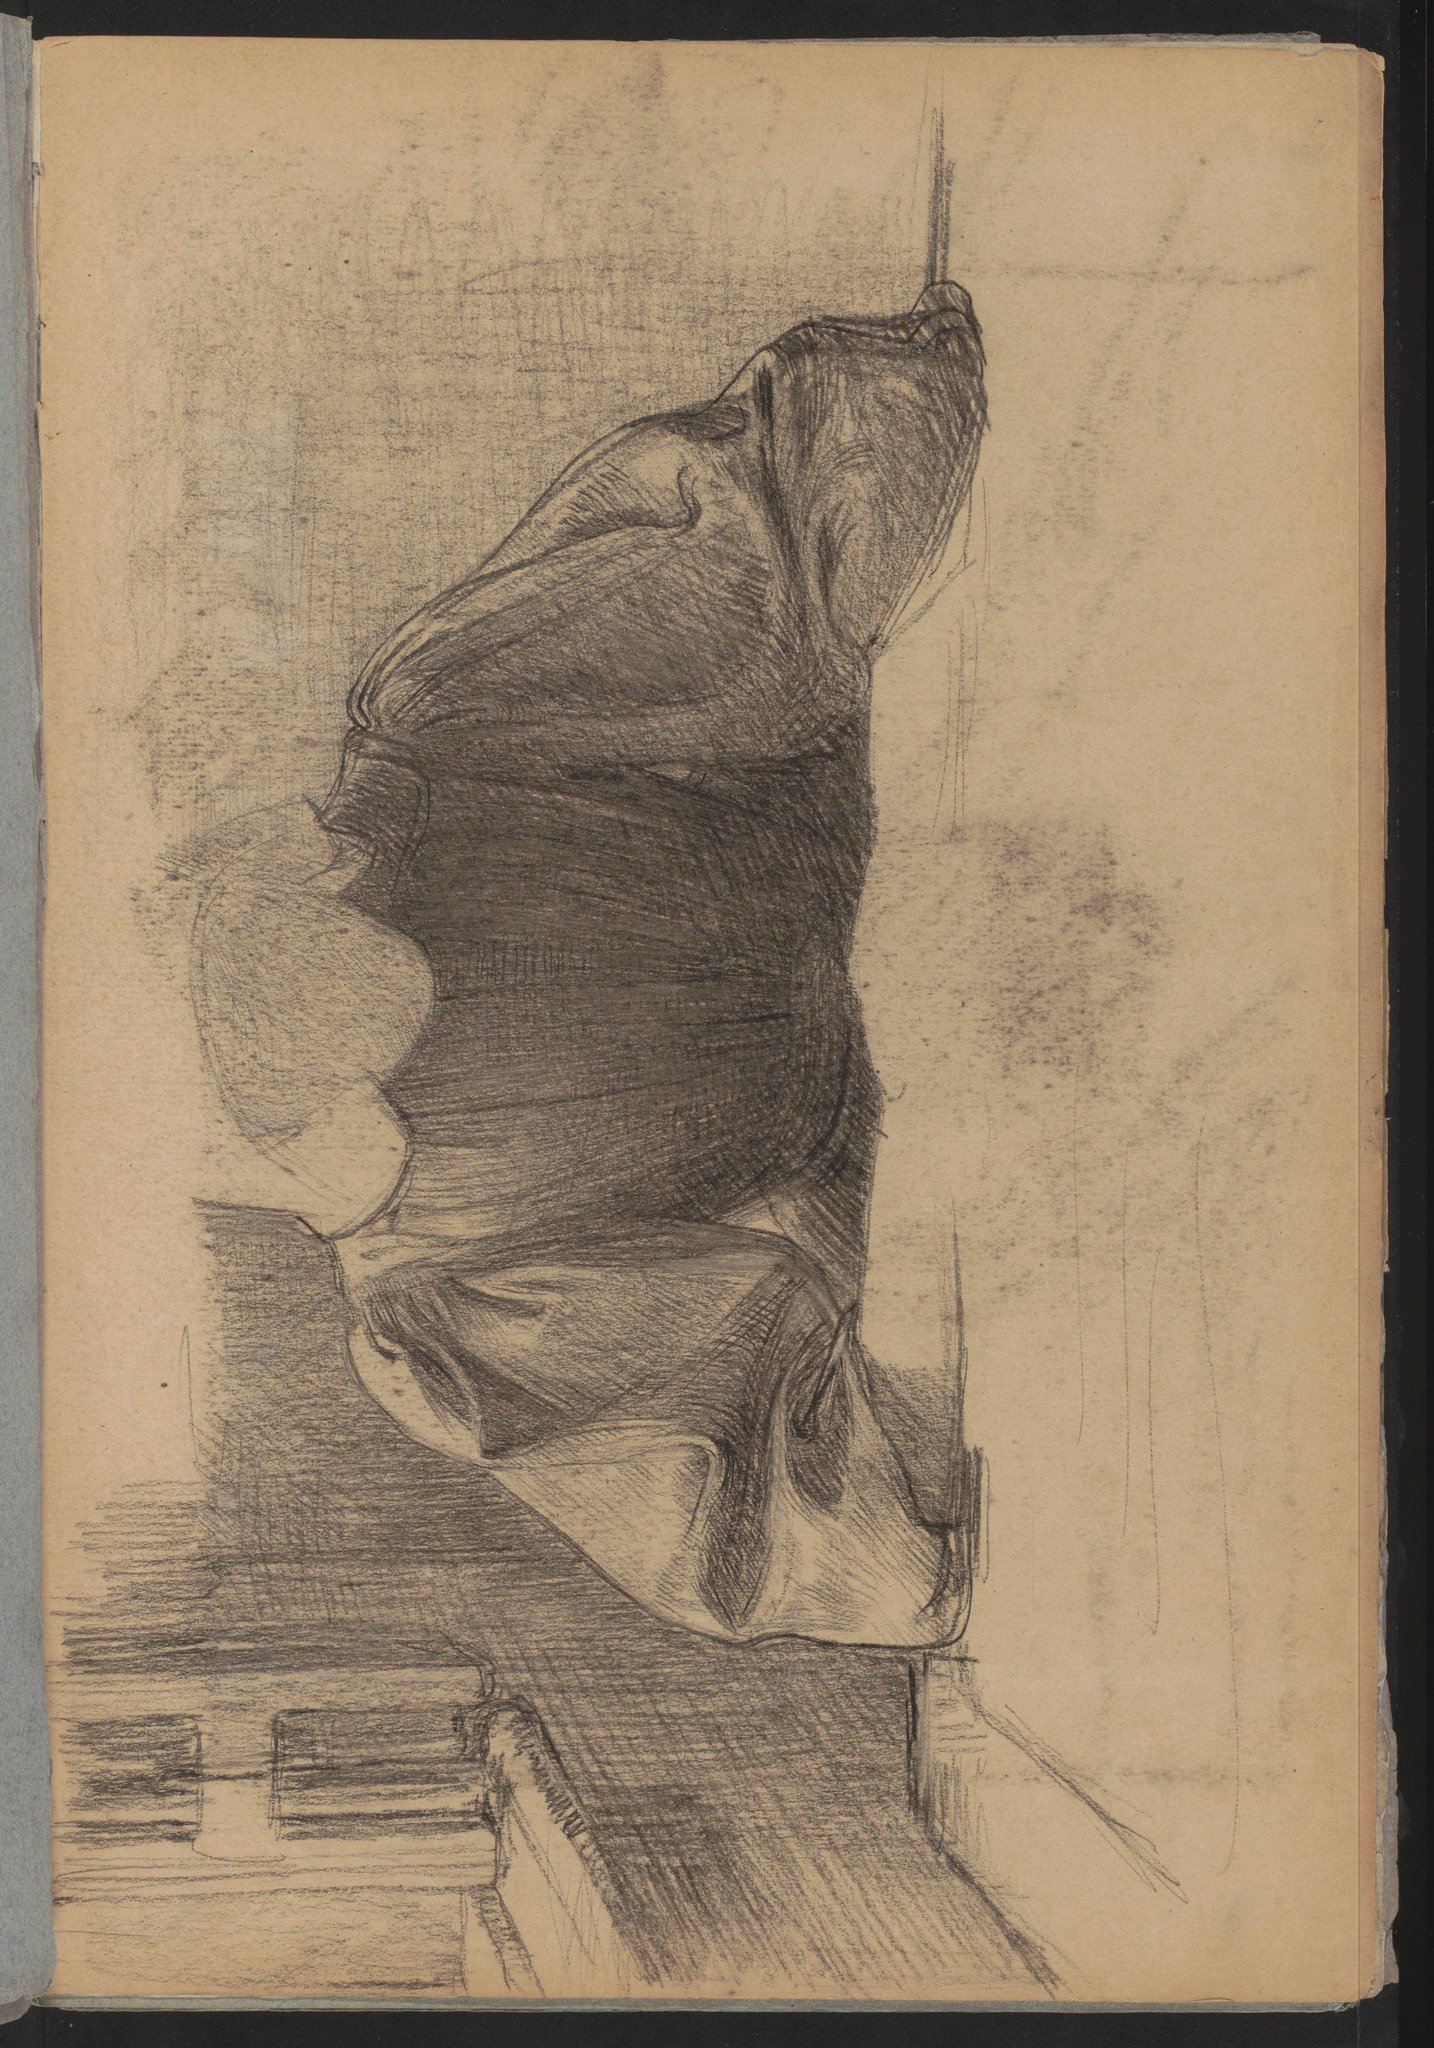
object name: sketchbook leaf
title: Vrouw met een boerenmuts gezeten aan een tafel bij een raam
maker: jan veth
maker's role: designer, draughtsman, painter, print maker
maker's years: 1864-1925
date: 1874-1925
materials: chalk, paper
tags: window, farmers - aa - female farmer, farmer's wife, head-gear: cap (+ women's clothes), table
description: De vrouw heeft de armen gevouwen op de tafel. Blad 13 recto uit een schetsboek met 42 bladen.